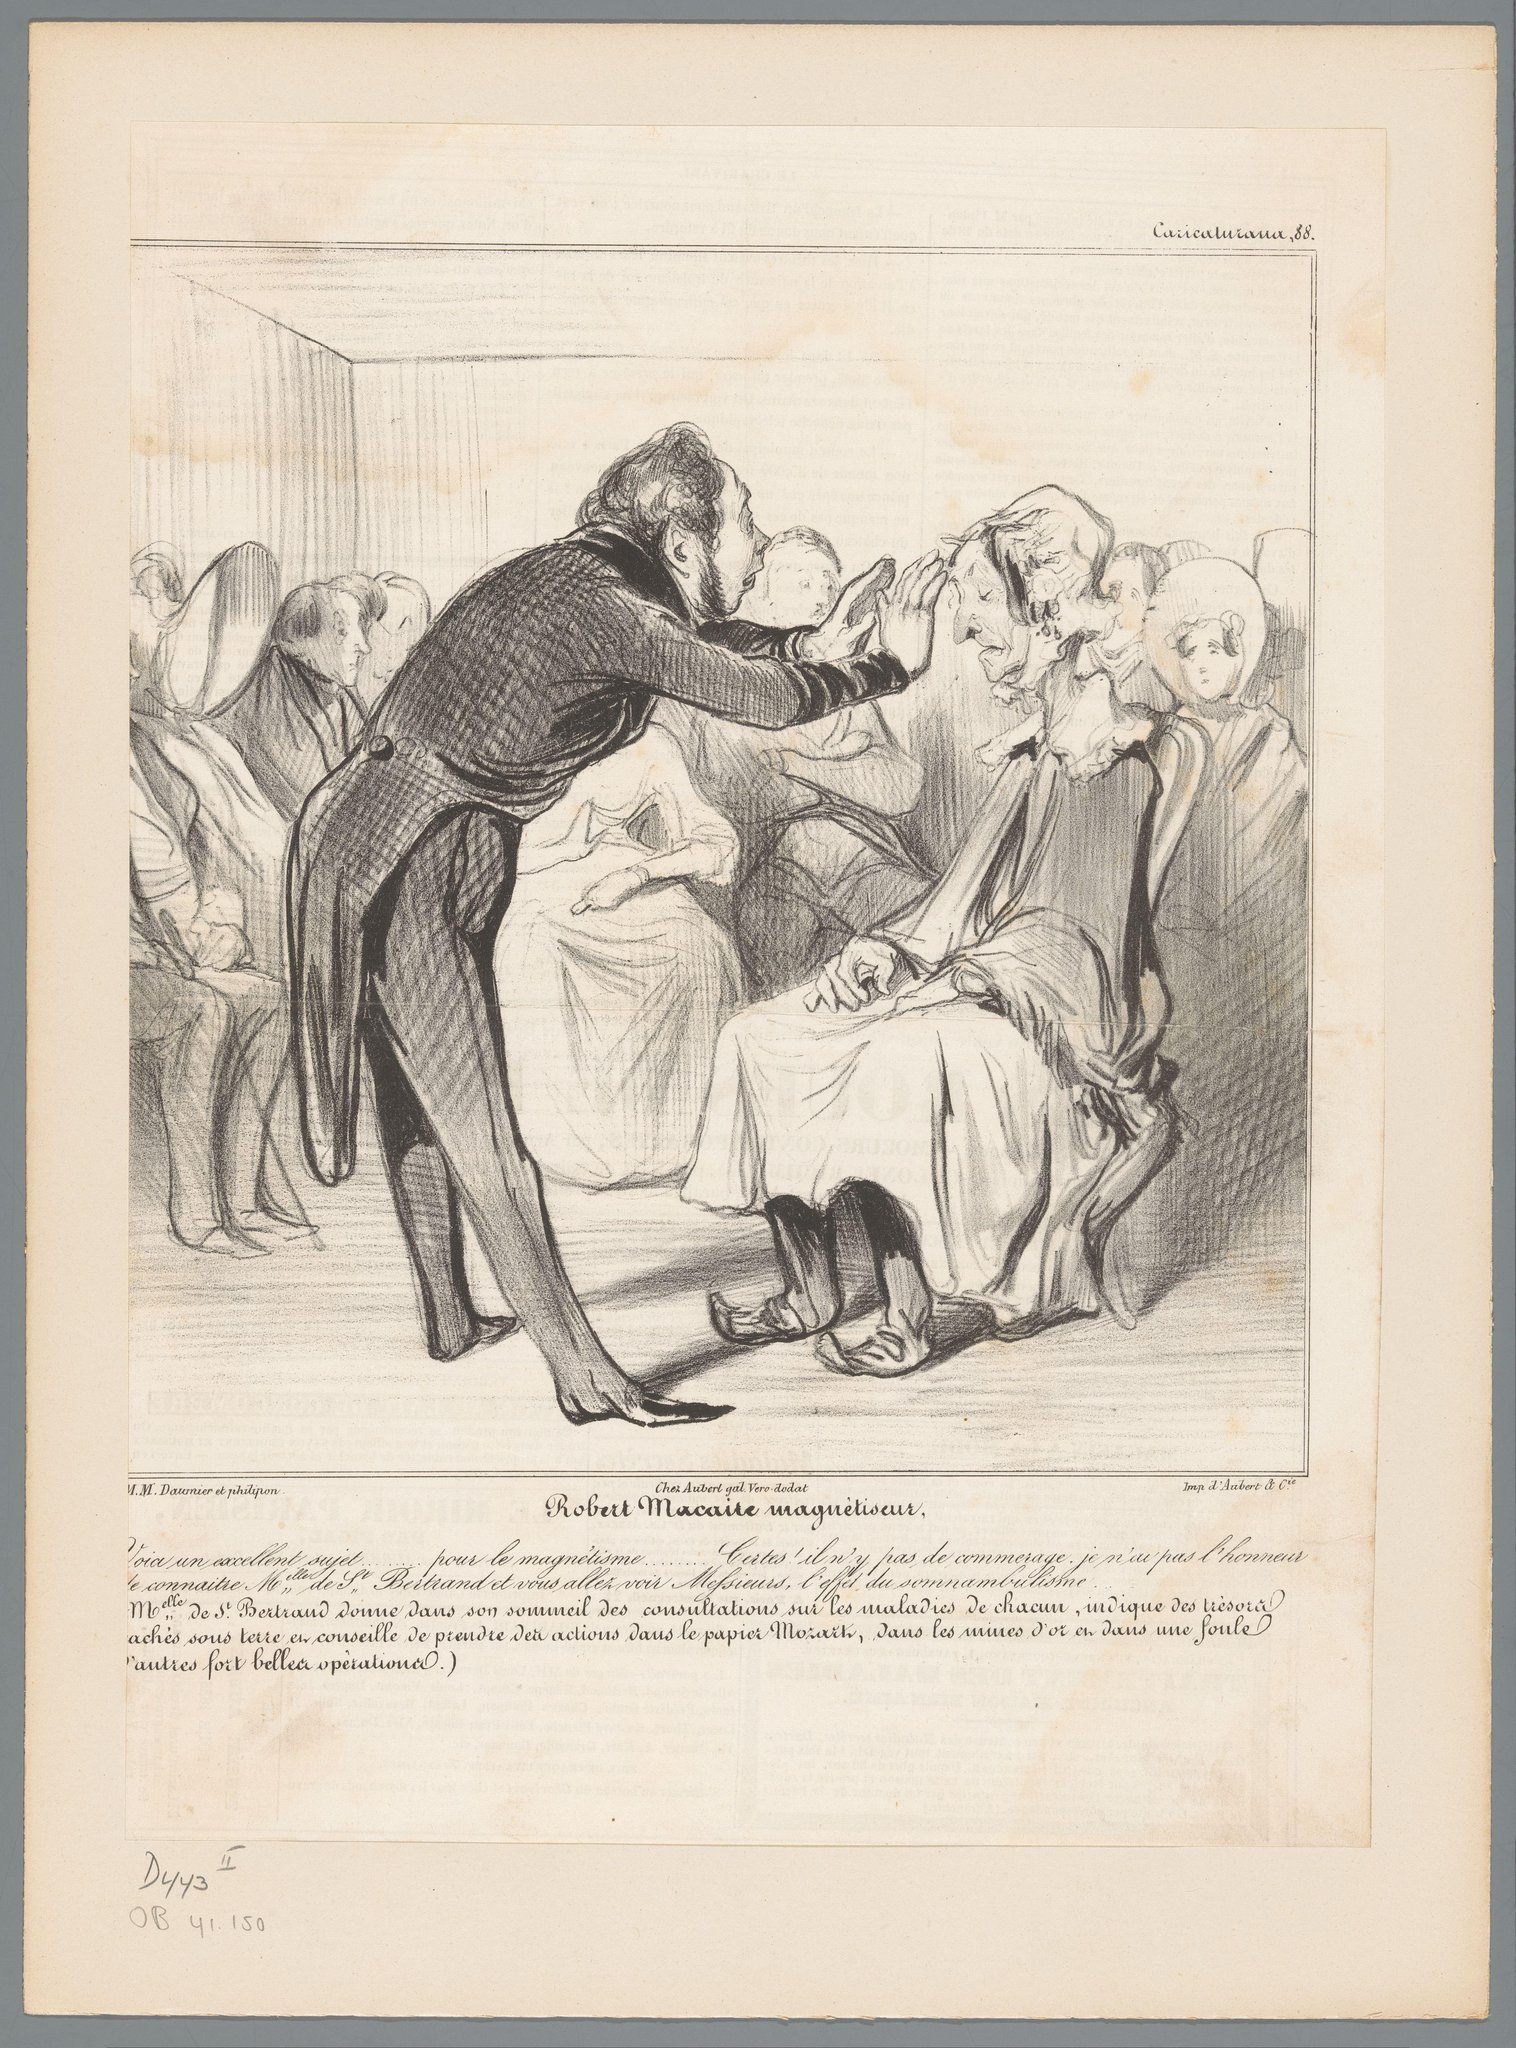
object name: cartoon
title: Caricaturana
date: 1838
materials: paper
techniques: letterpress printing, lithograph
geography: paris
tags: magic healings, caricatures (human types), disguise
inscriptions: collector's mark: Lugt 2228a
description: Prent mogelijk uit: Le Charivari, 26 augustus 1838.